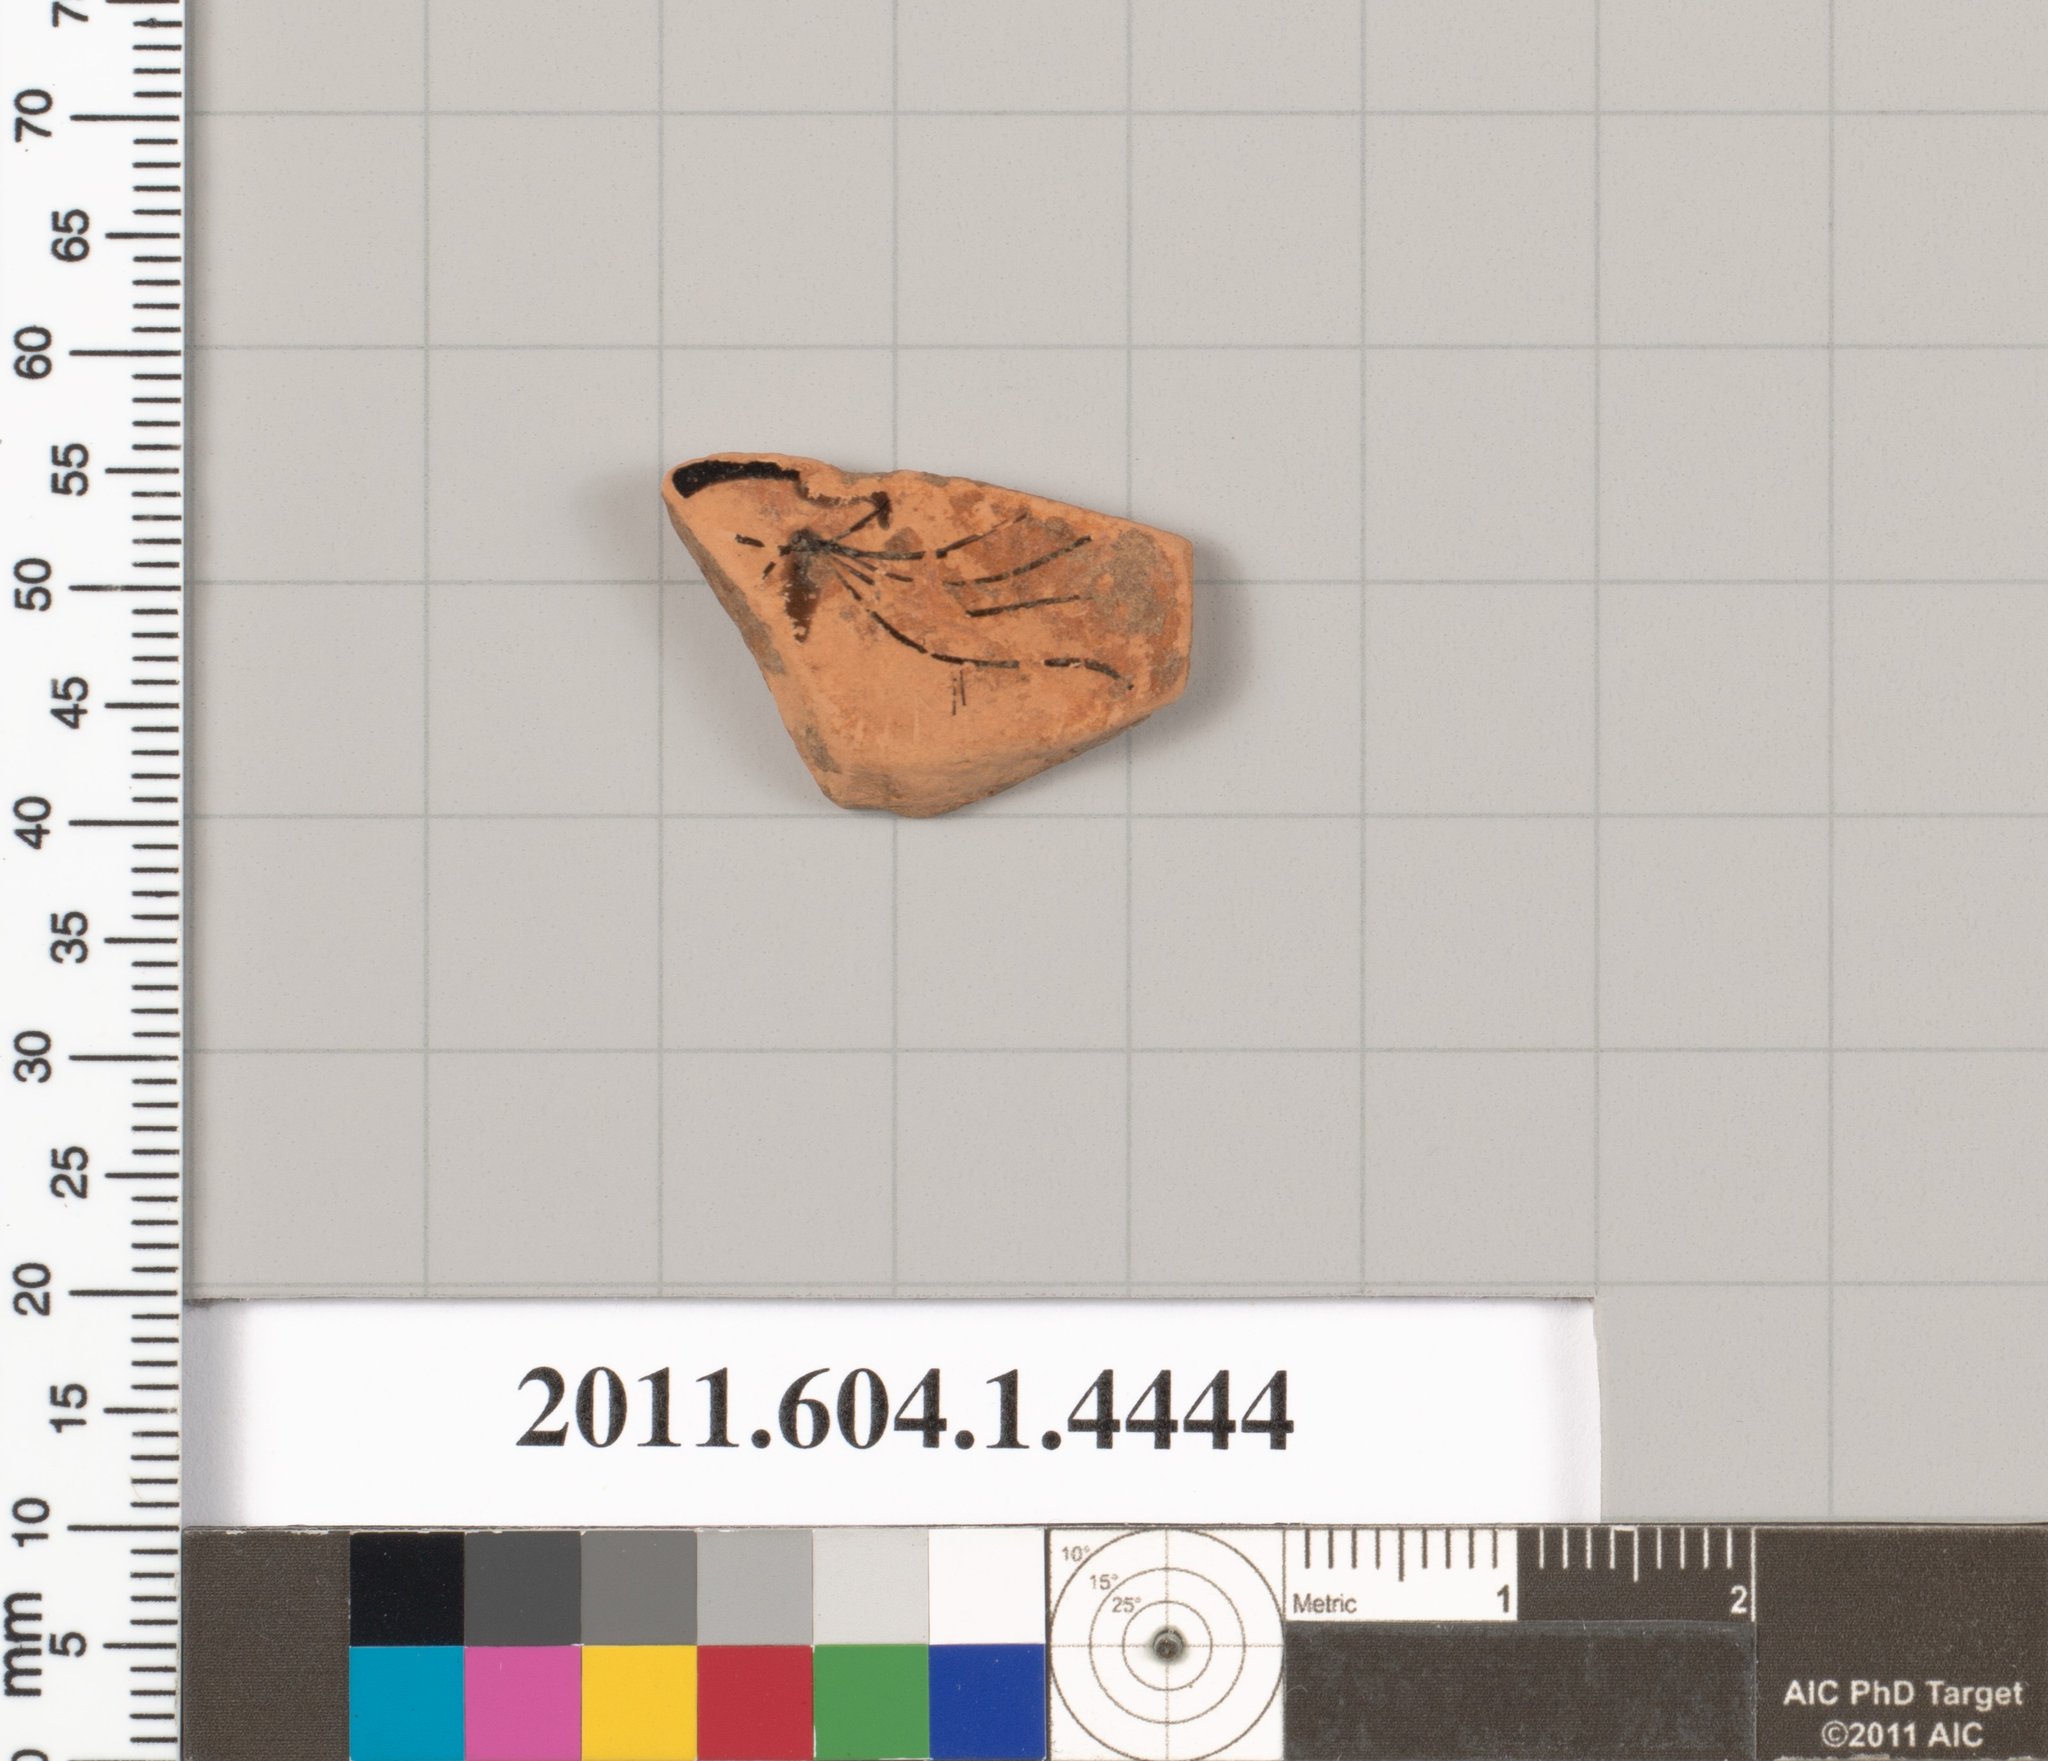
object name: kylix fragment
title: Terracotta fragment of a kylix (drinking cup)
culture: greek, attic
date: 475-451 BCE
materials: terracotta